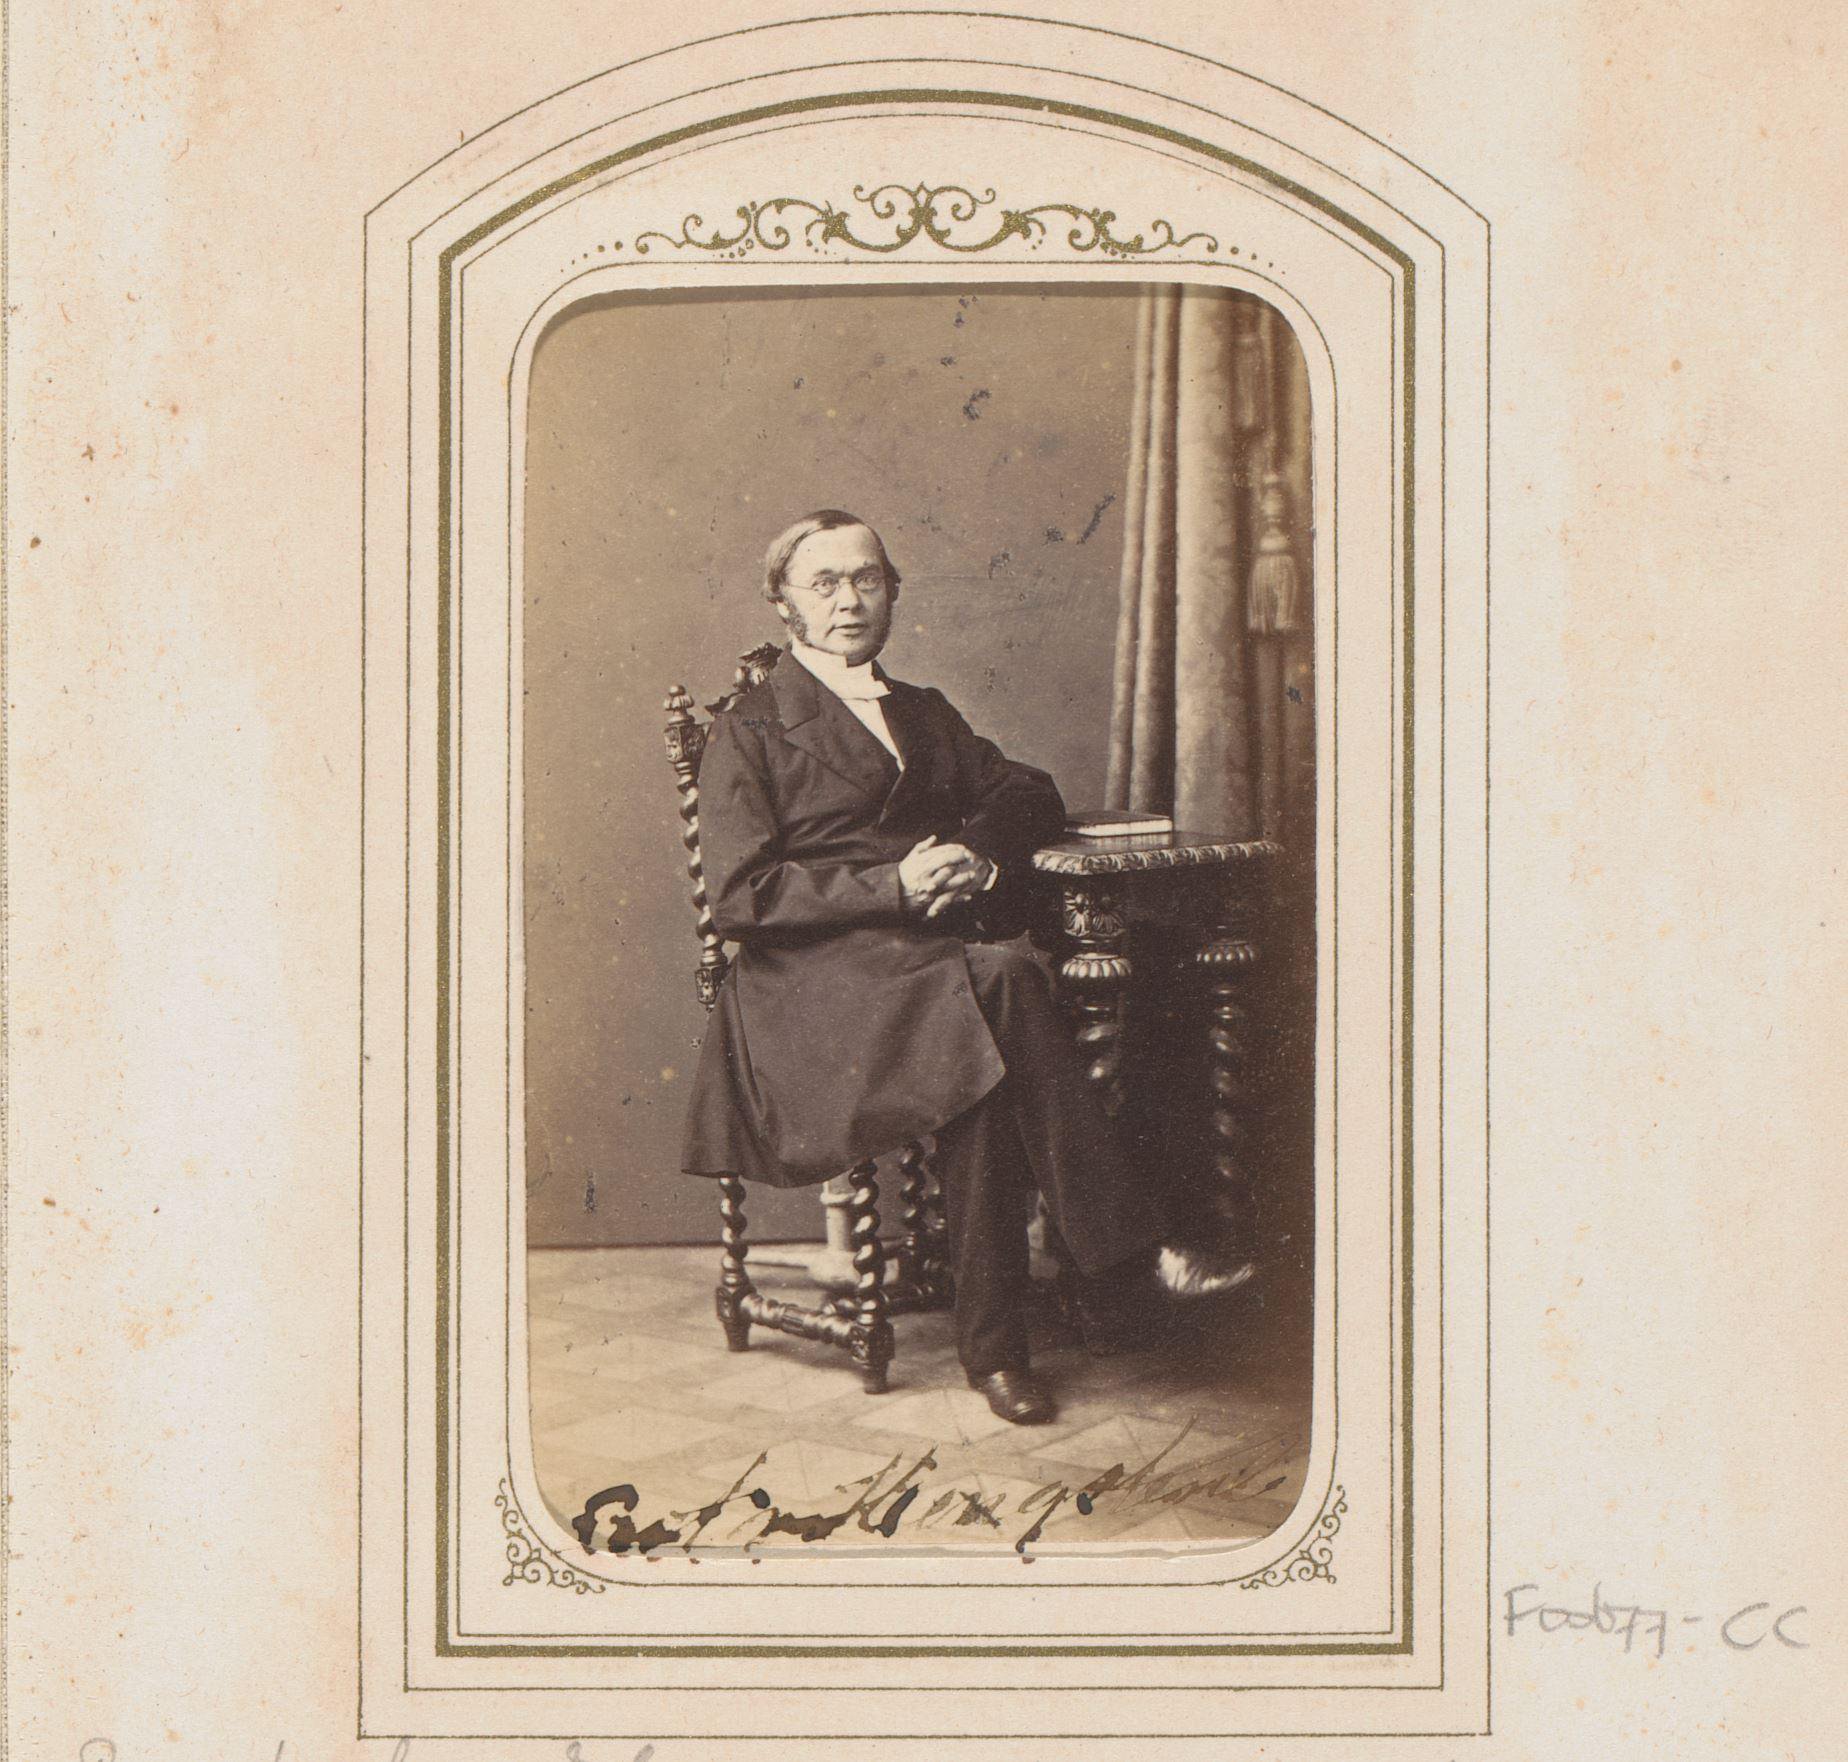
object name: album leaf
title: Portret van Ernst Wilhelm Hengstenberg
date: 1850-1869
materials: cardboard, photographic support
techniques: albumen print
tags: theologian, historical persons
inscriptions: name: ‘Ernst Hengstenberg’, name: ‘Hengstenberg’, inscription: ‘L. Haase & Comp./ Königl. Hof-Photographen/ u. Hof-Photographen I.K.H. d. Frau Kronprinzessin v. Preussen./ BERLIN/ Friedrichsstr./ No. 178./ KŒLN/ Königin-Augusta-Halle/ (Passage) No. 39./ BRESLAU/ Tauenzienstr./ No. 10.’, annotation: ‘Erwin Wilhelm Hengstenberg 1802/68/ D theoloog’